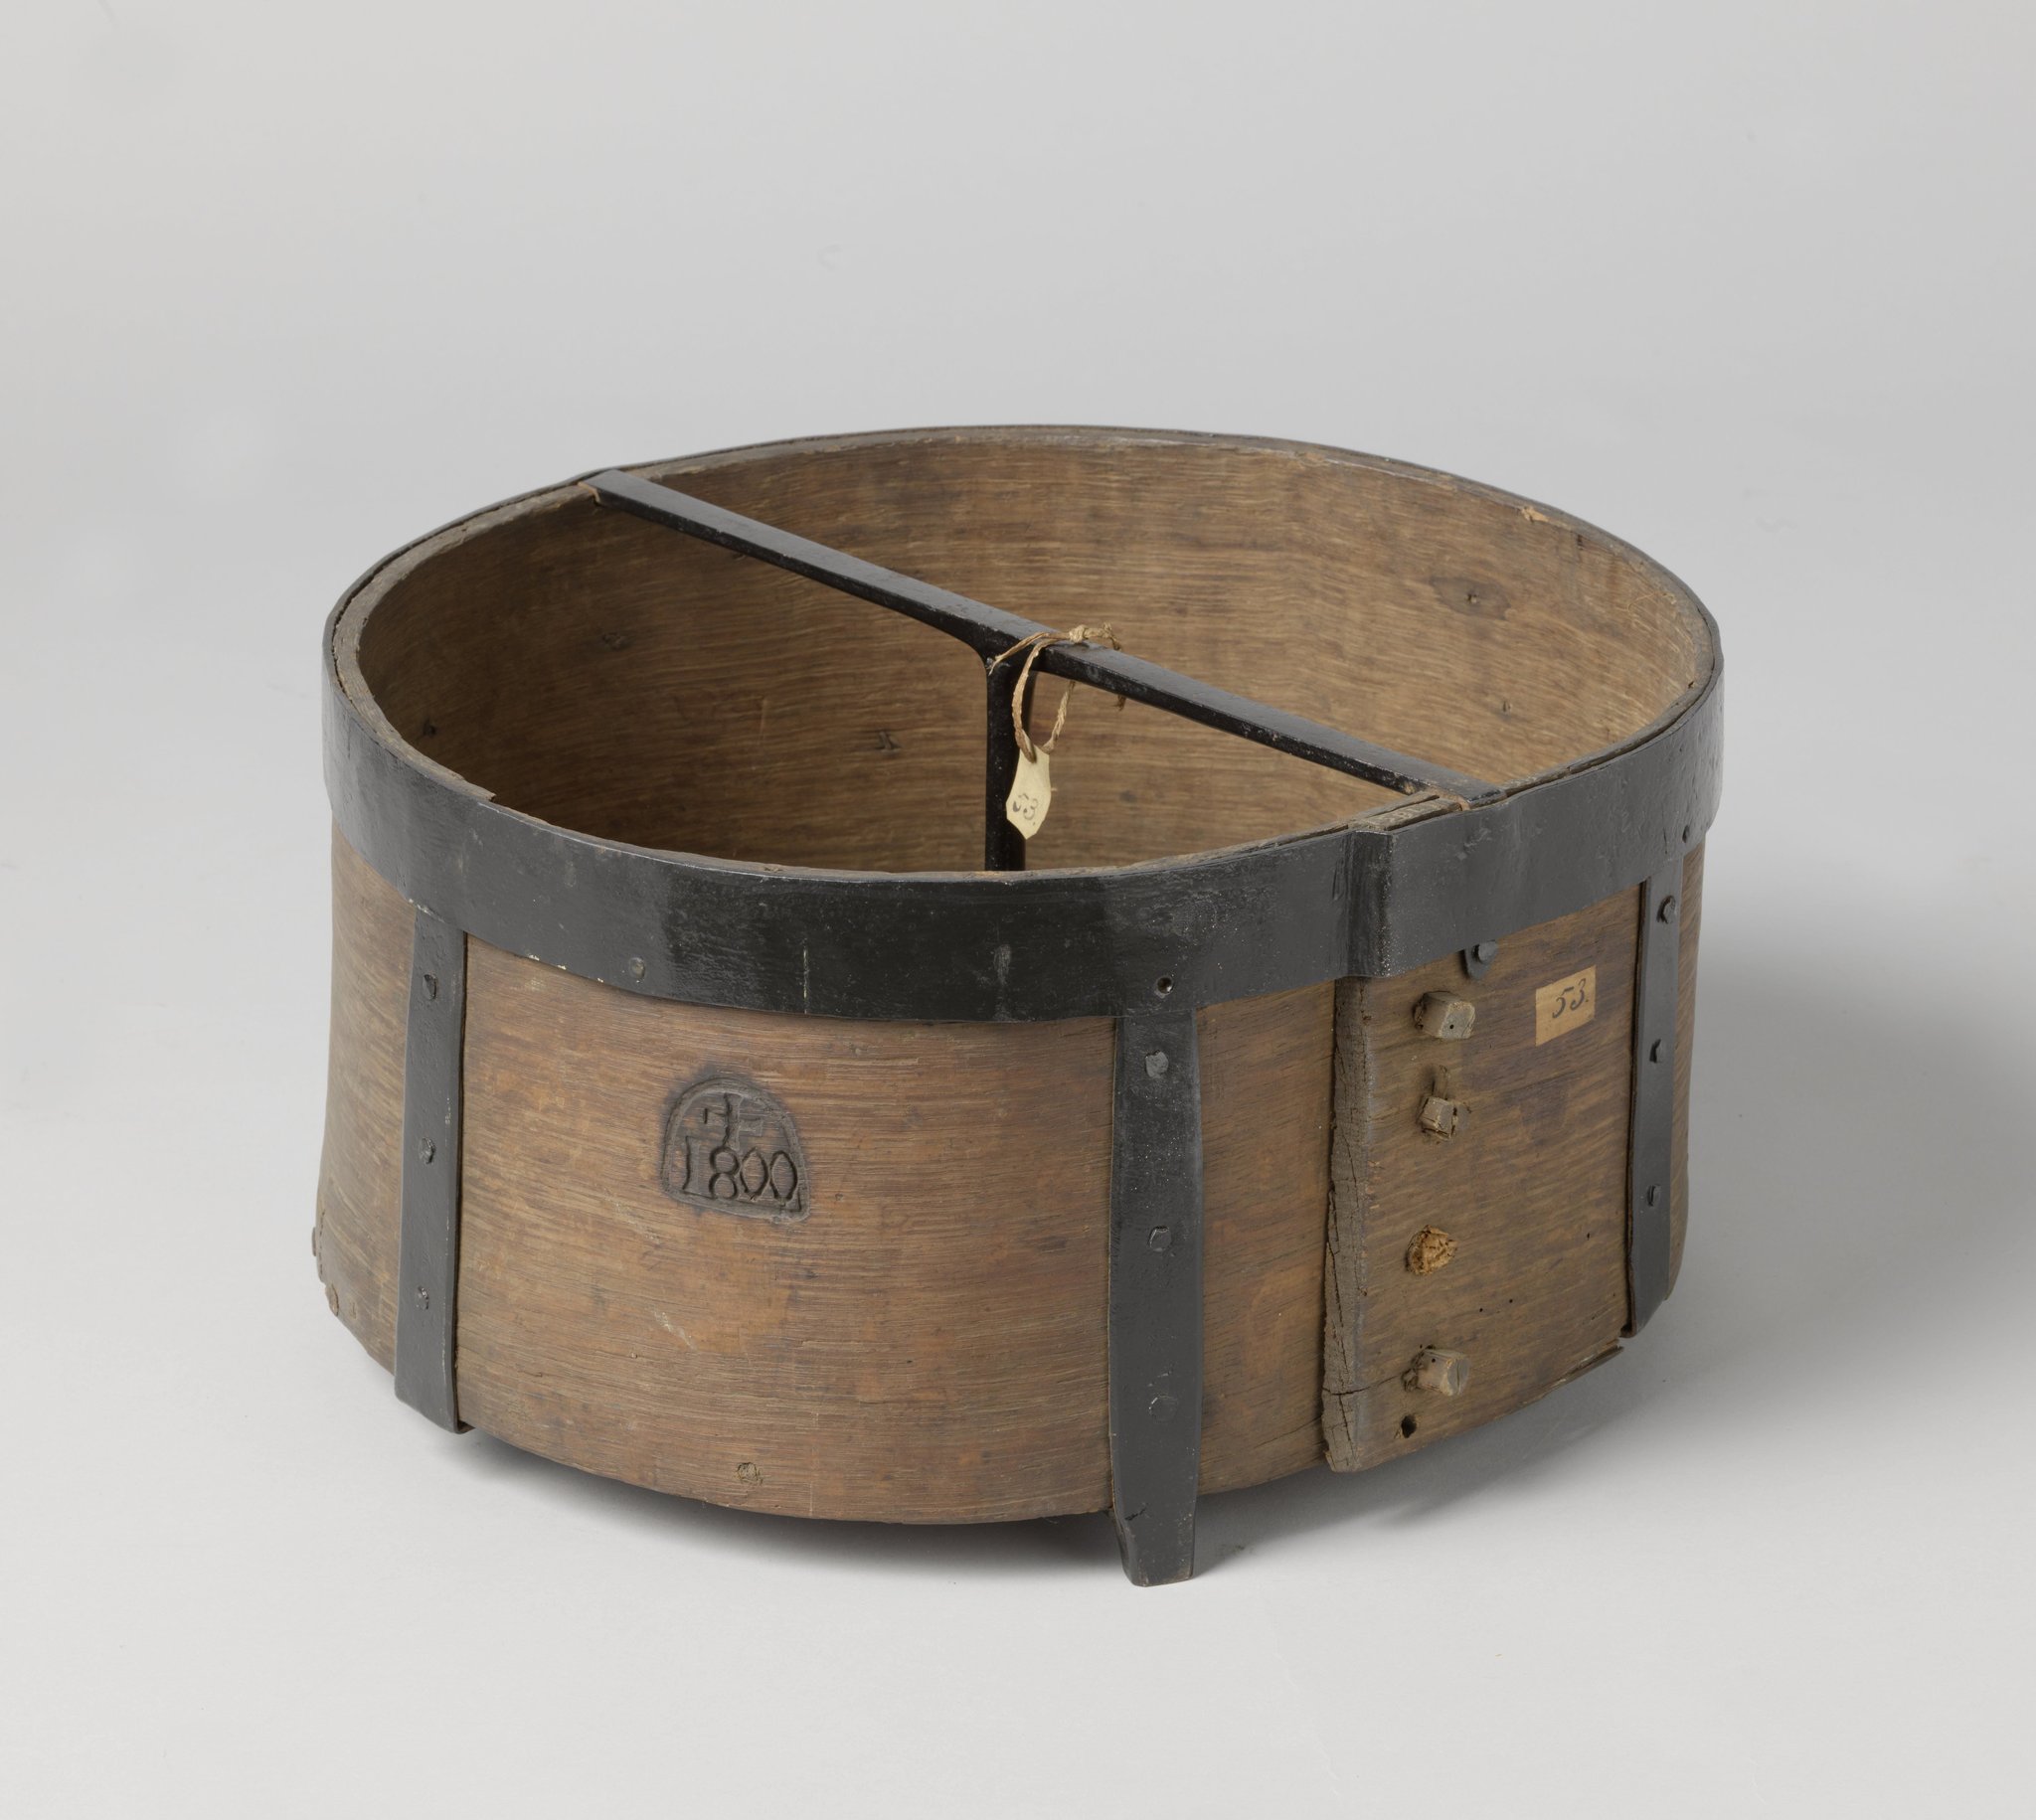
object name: inhoudsmaat droge waren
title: 1 Schepel uit Groenlo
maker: Anonymous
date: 1800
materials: iron, wood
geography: groenlo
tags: groenlo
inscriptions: number: ‘53’, mark, title: ‘de Groenlo un Boisseau’, title: ‘Groenlo Een Schepel’, mark: ‘+ 1800’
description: Houten en ijzeren inhoudsmaat voor droge waren met brug en stijl van 1 schepel, v.z.v. stempel en etiketten.